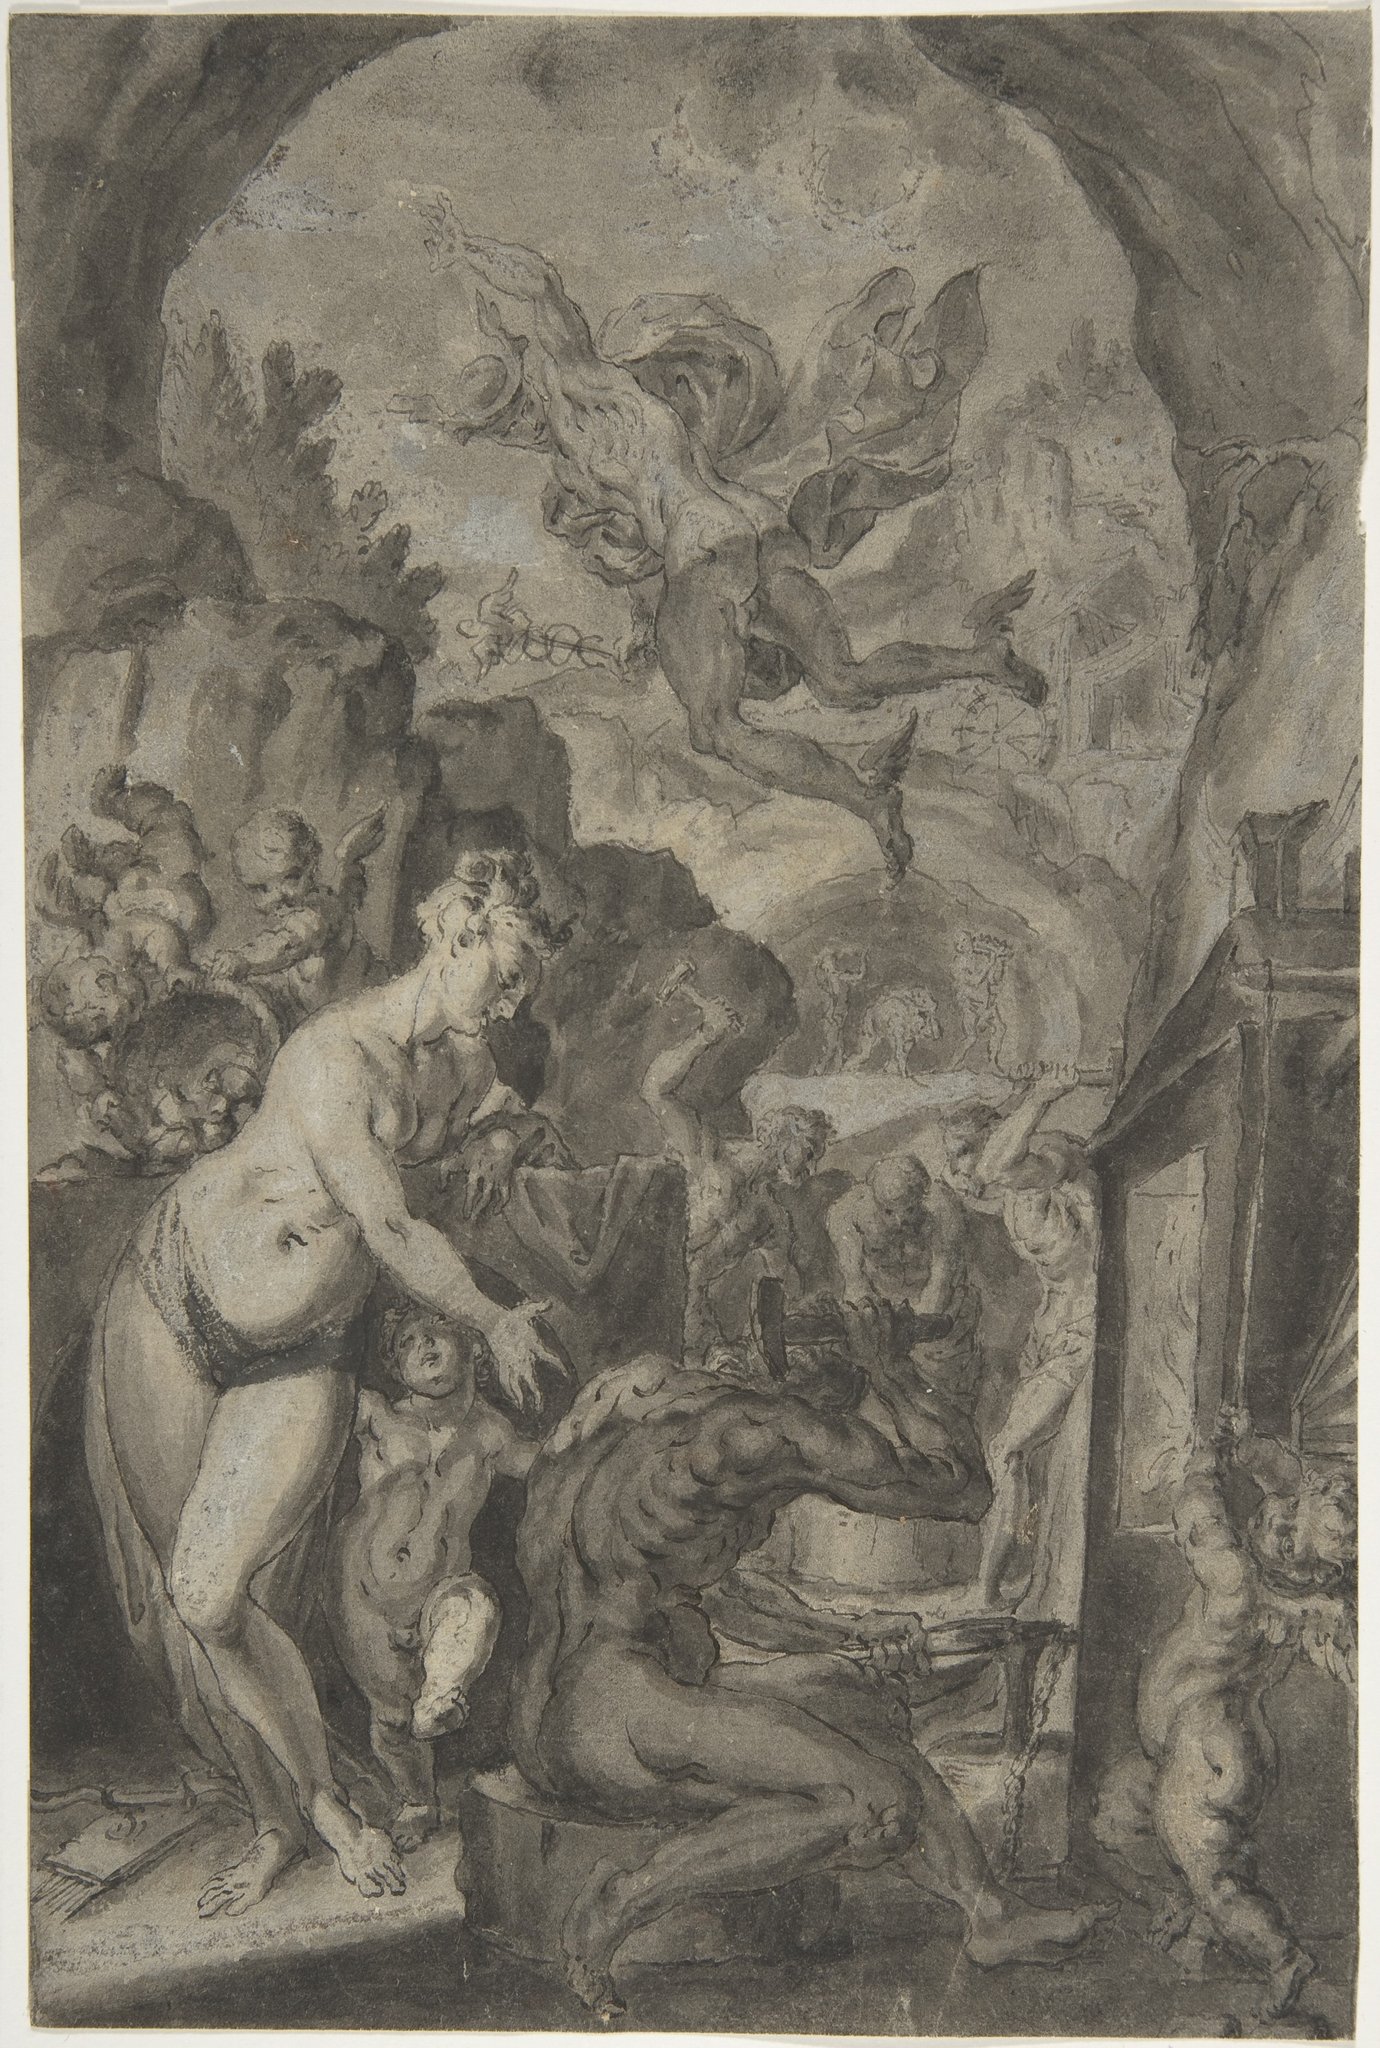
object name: drawing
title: Venus in the Forge of Vulcan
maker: anonymous, german, 17th century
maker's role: artist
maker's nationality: german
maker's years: 1600-1700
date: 1605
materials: ink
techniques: heightening, pen, wash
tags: venus,vulcan